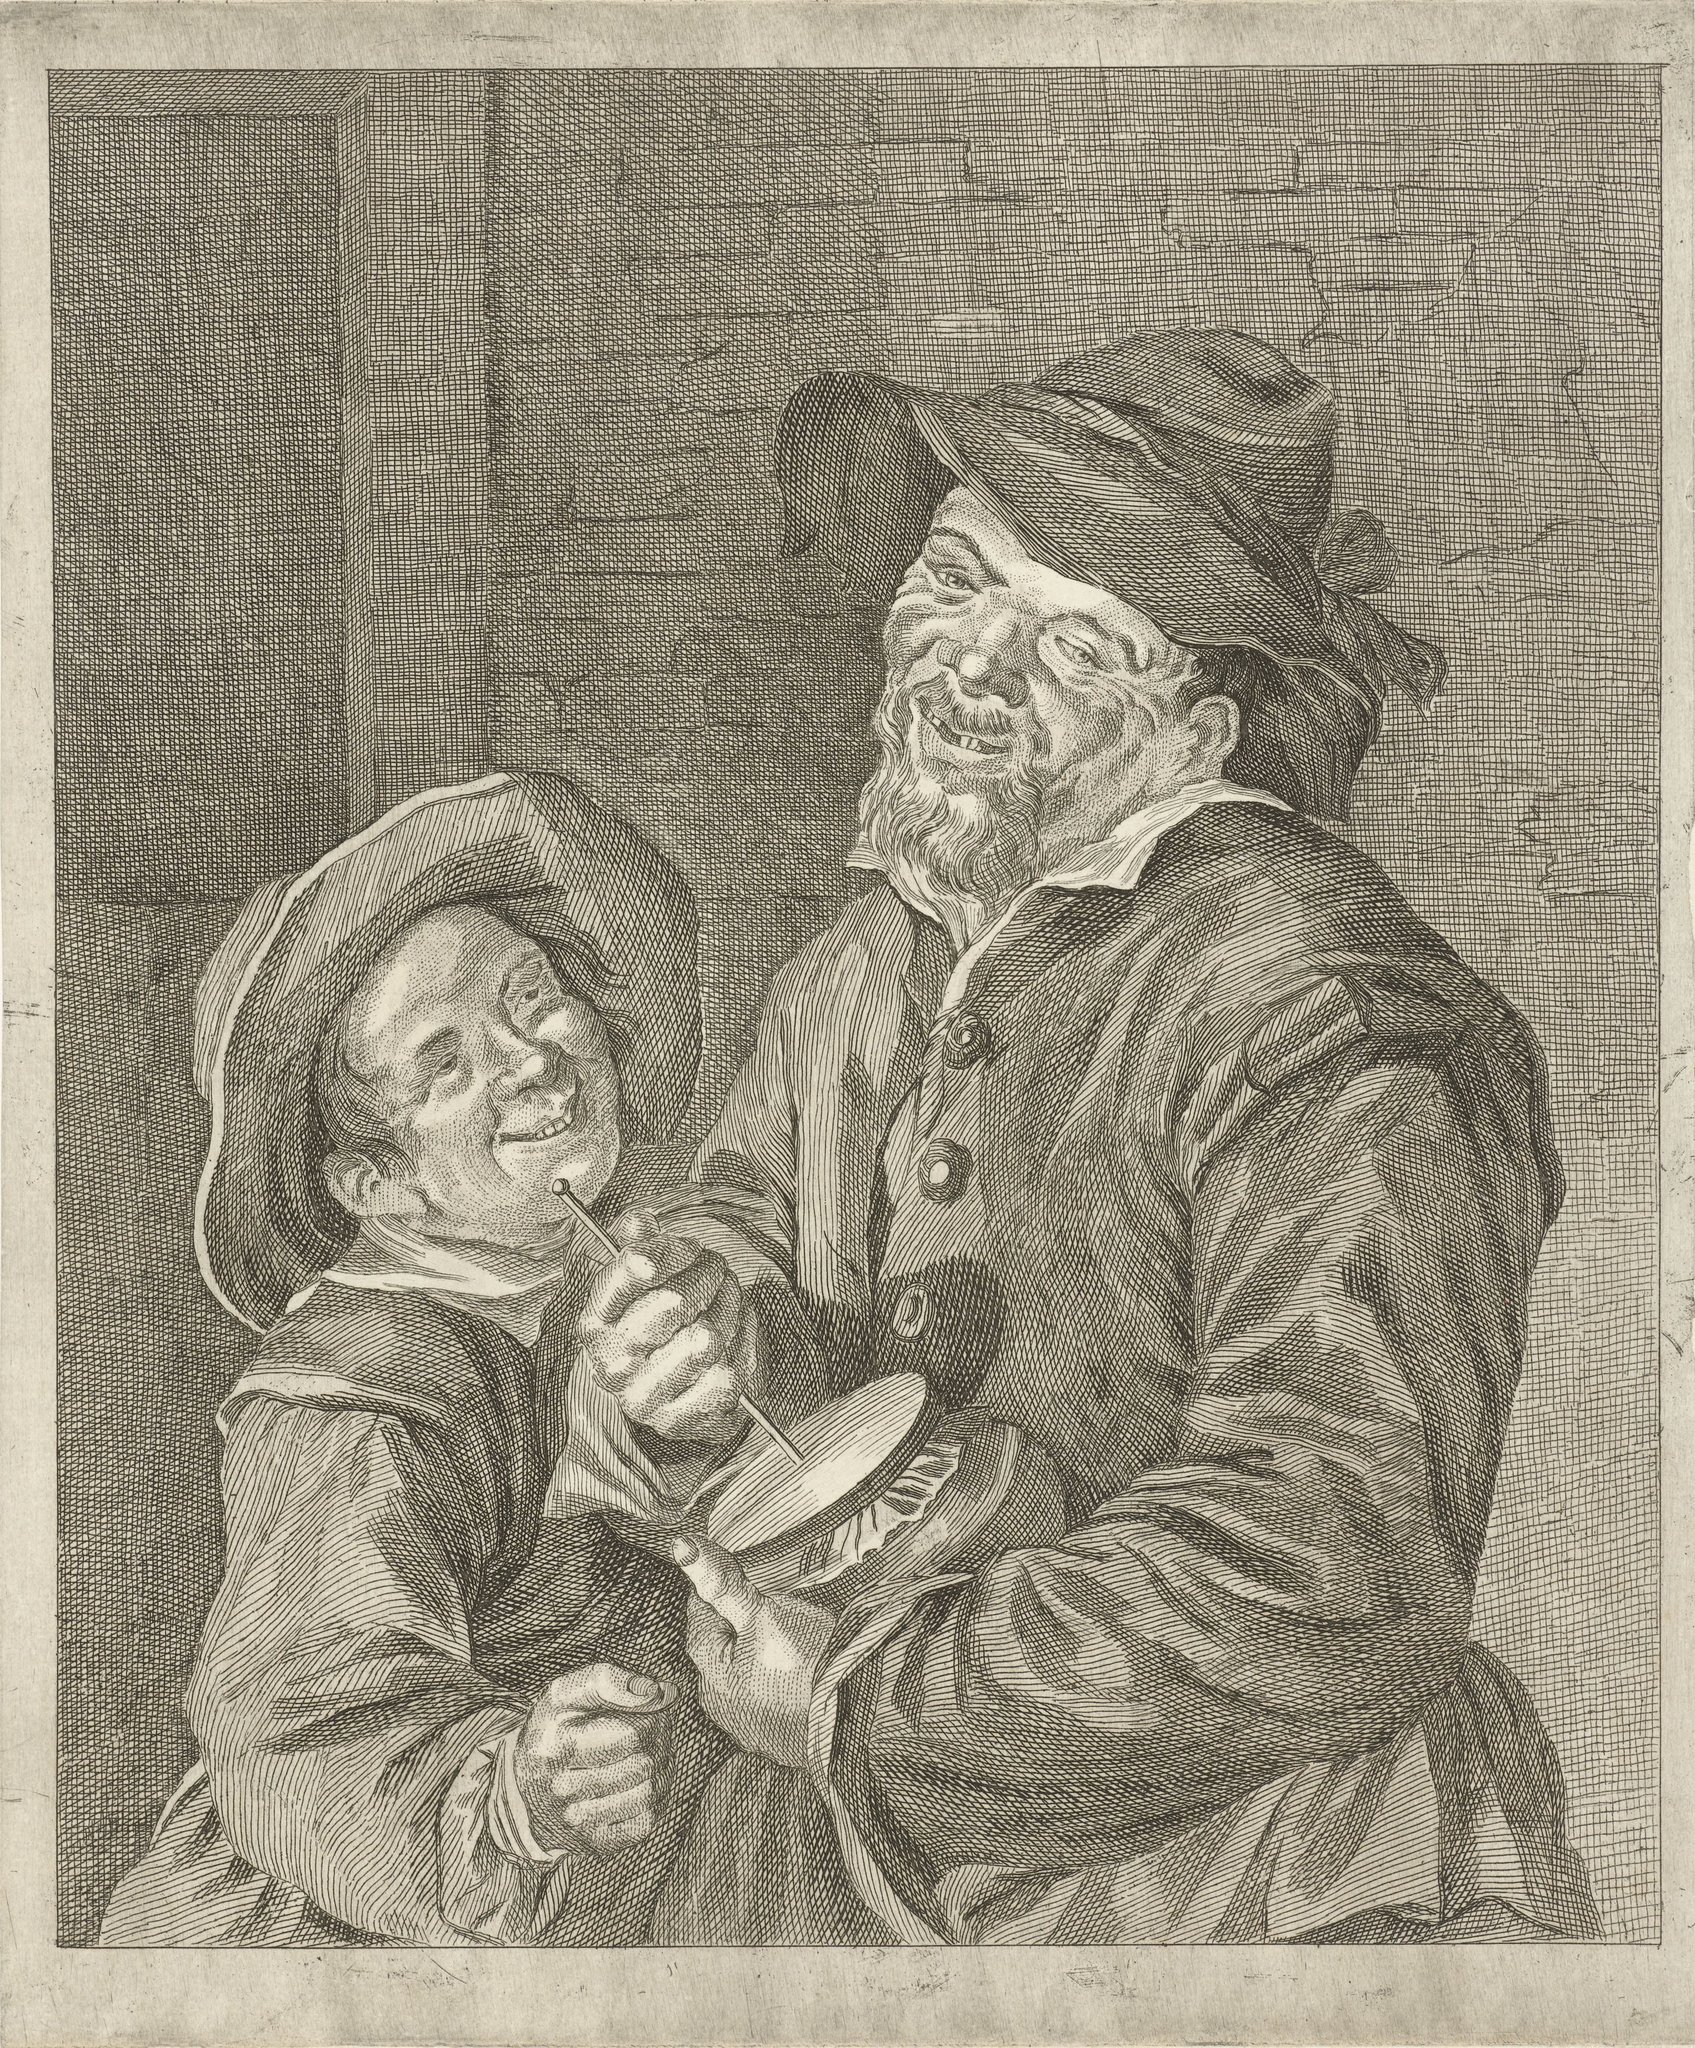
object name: print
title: De rommelpotspeler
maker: pieter de mare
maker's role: print maker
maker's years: 1758-1796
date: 1768-1796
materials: paper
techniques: etching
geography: leiden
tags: one person playing wind instrument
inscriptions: collector's mark: Lugt 240